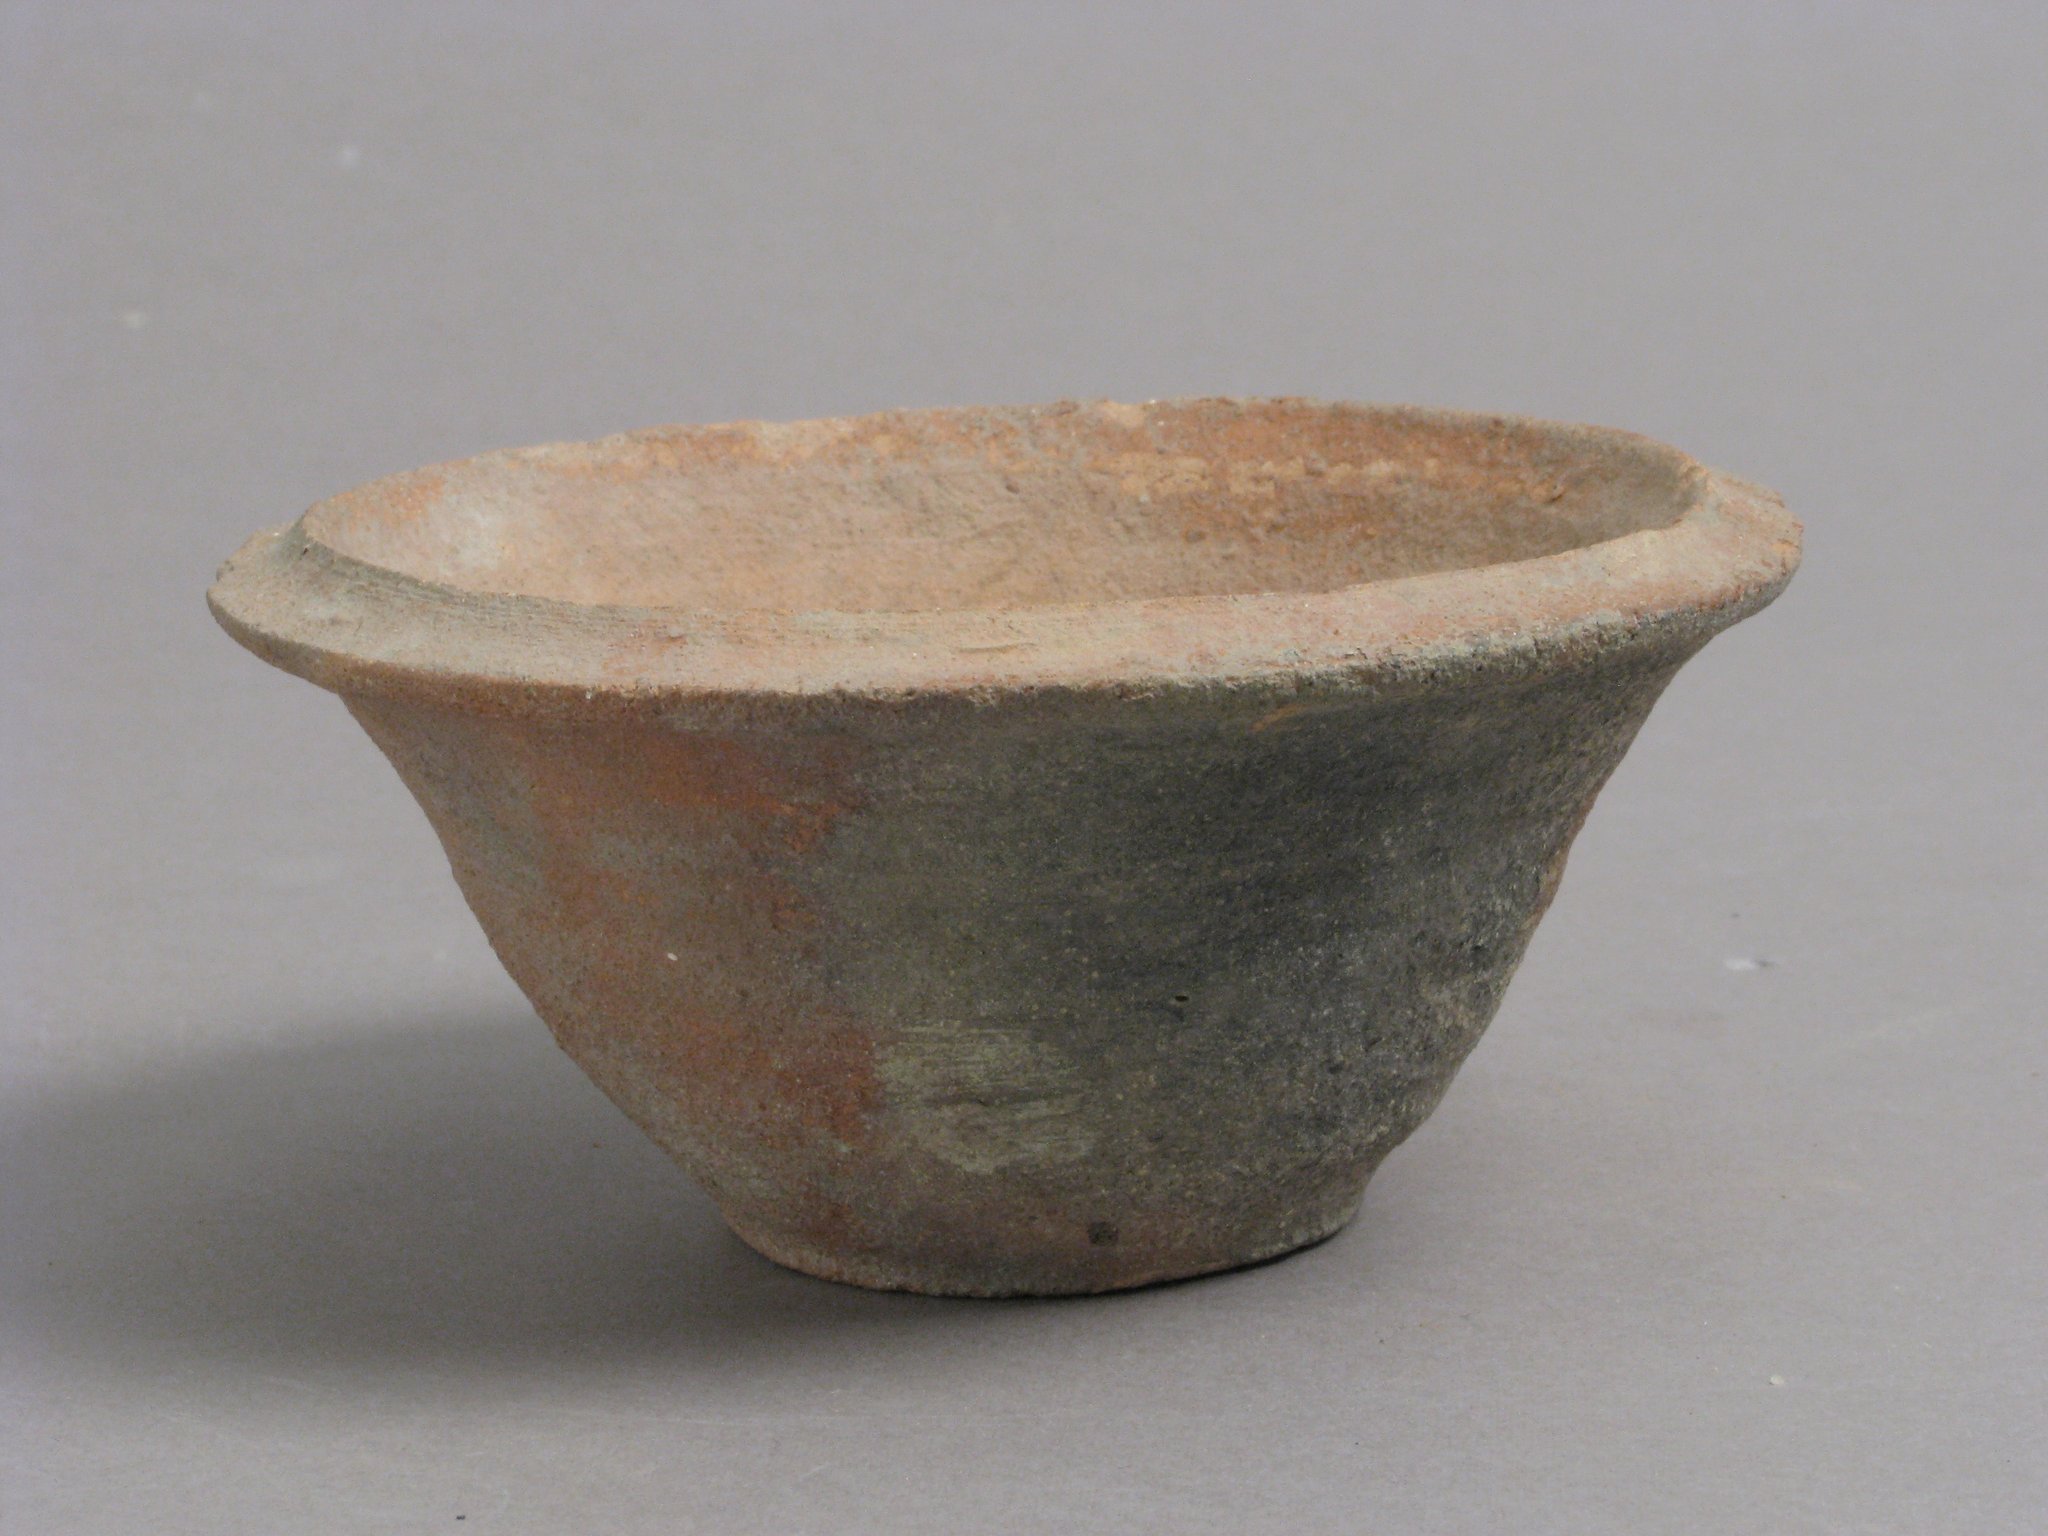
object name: bowl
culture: coptic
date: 301-700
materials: earthenware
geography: egypt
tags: bowls